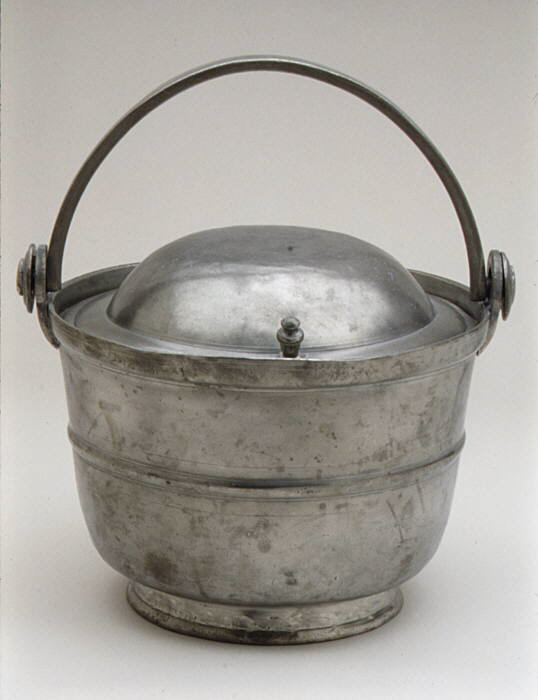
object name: dinner pail with cover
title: Dinner pail with cover (porte-dîner)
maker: p. a. salmon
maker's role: maker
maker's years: 1750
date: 1734-1766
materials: pewter